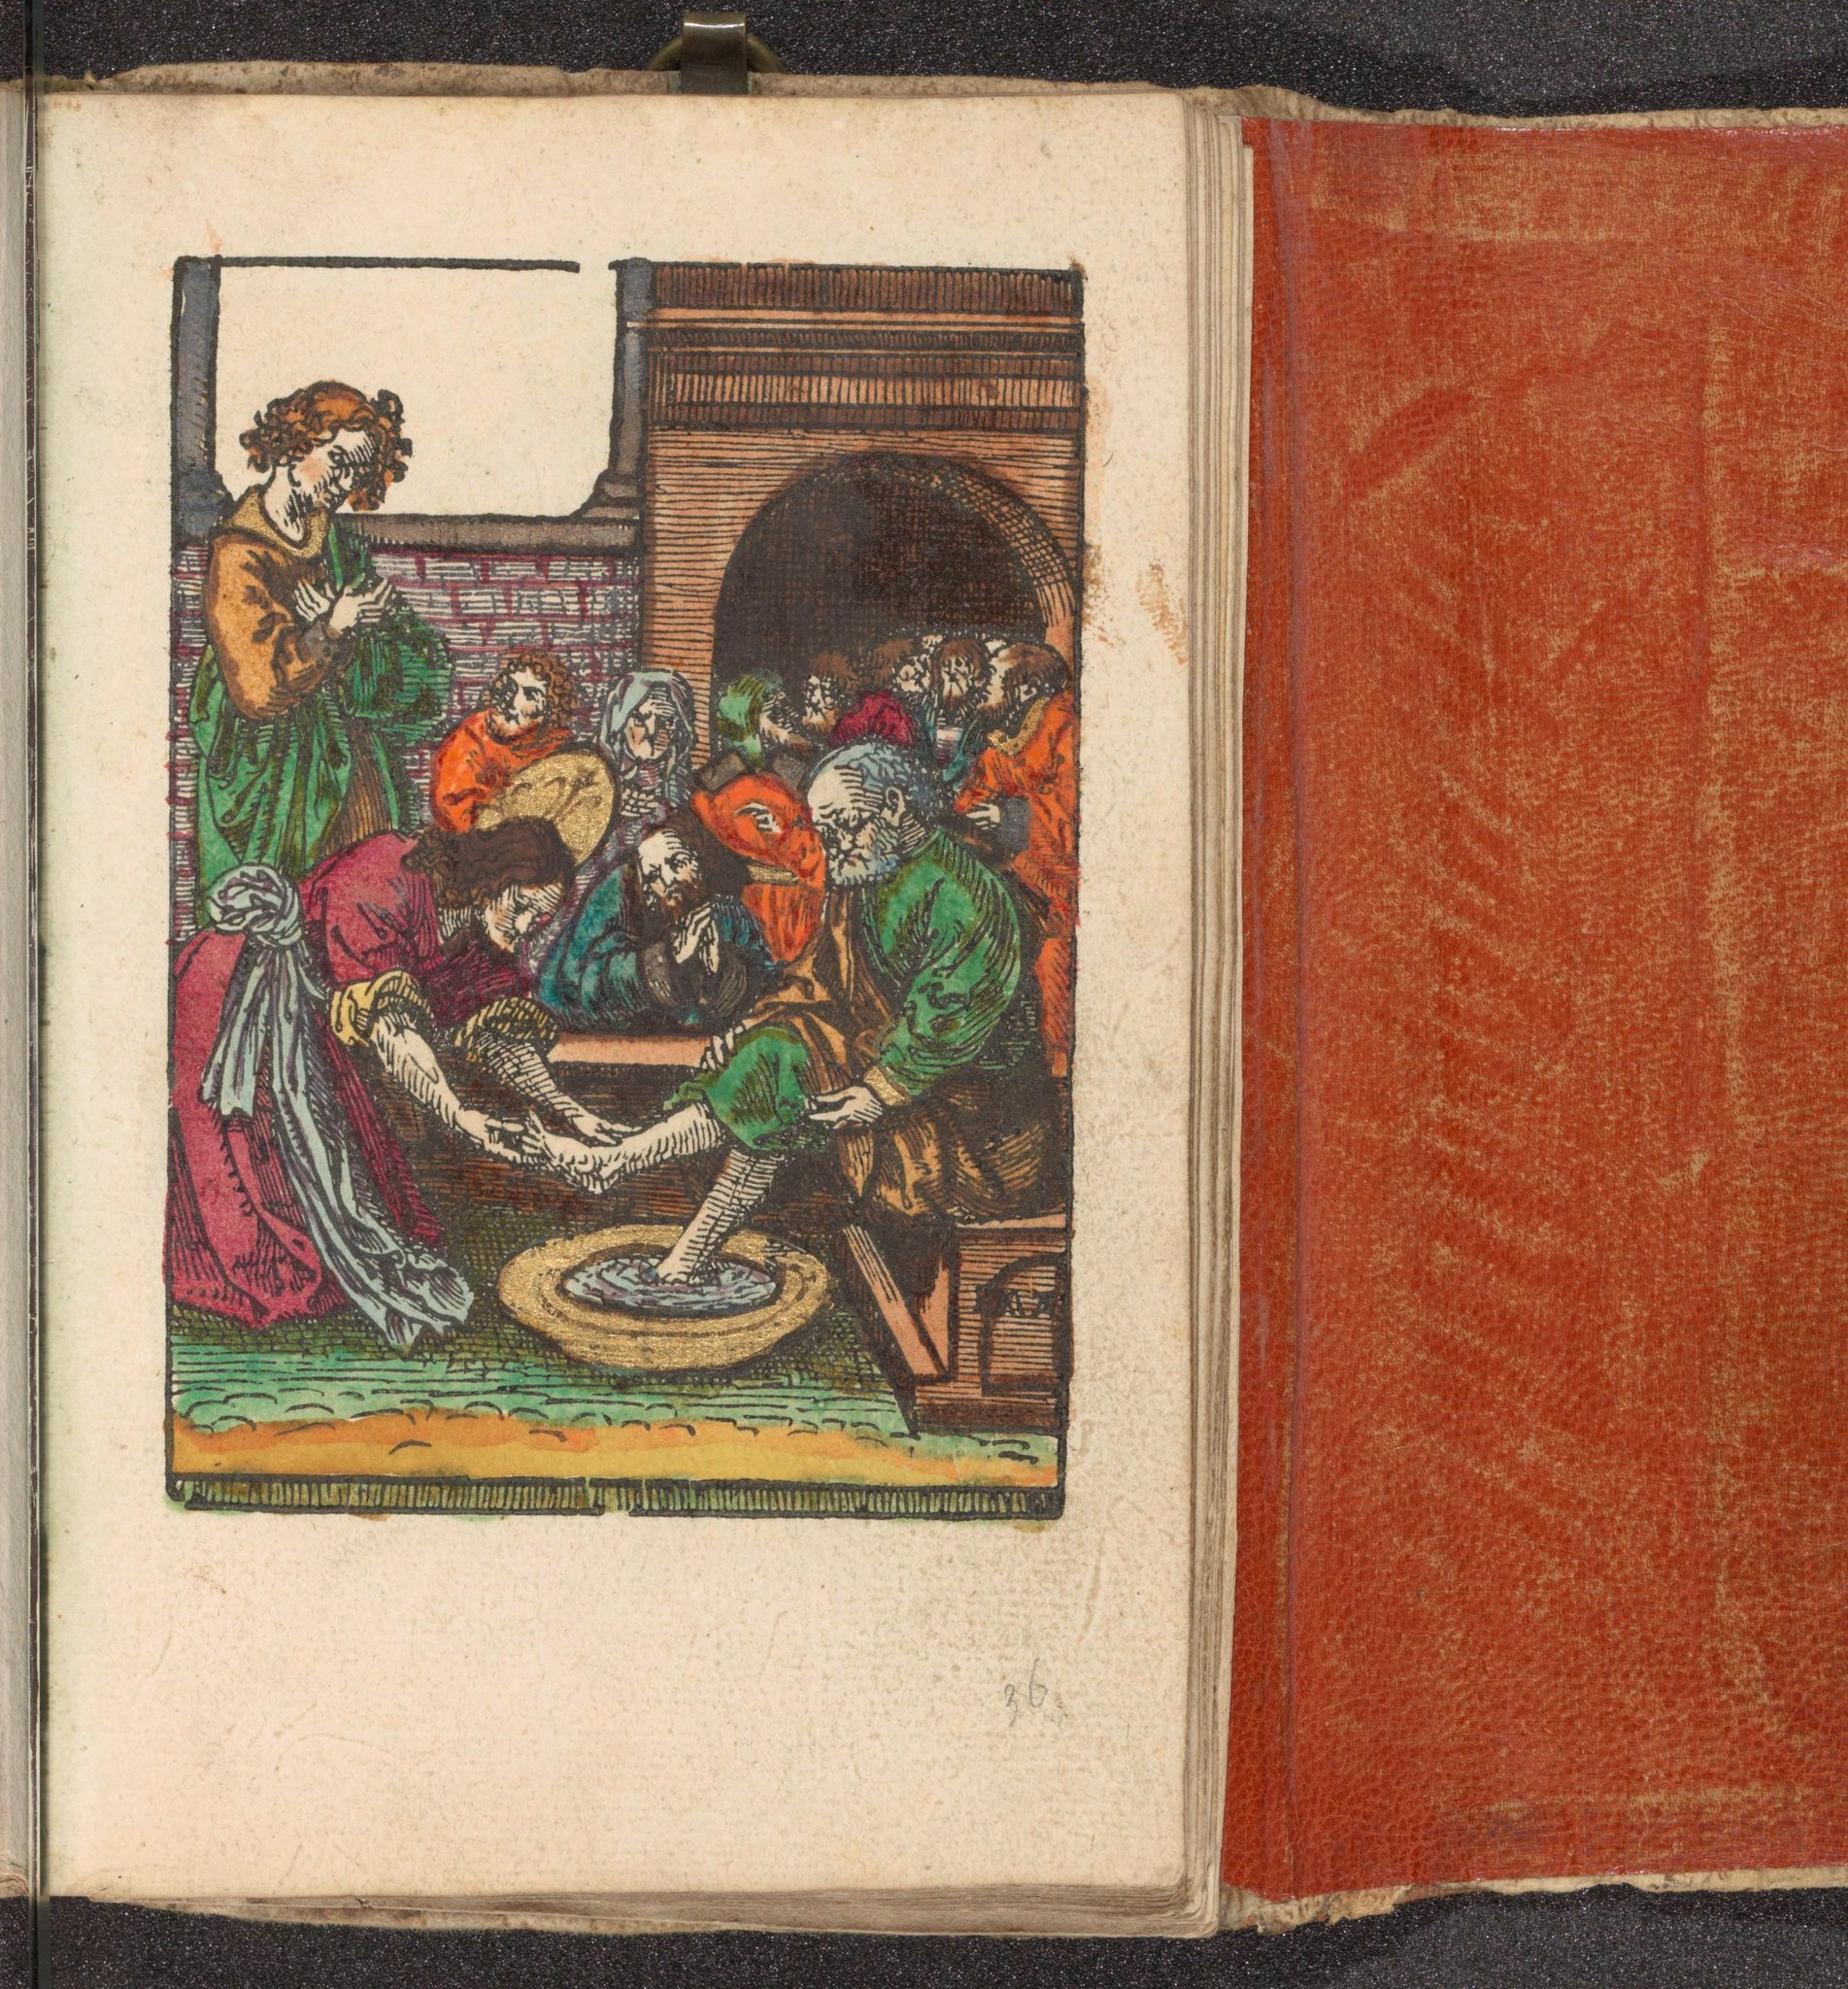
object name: book illustration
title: Voetwassing van Petrus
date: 1520-1521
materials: paper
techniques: hand coloring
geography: amsterdam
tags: christ washes peter's feet, book in which illustrations are essential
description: Christus wast de voeten van Petrus. De andere discipelen kijken toe. Prent maakt deel uit van een boek.